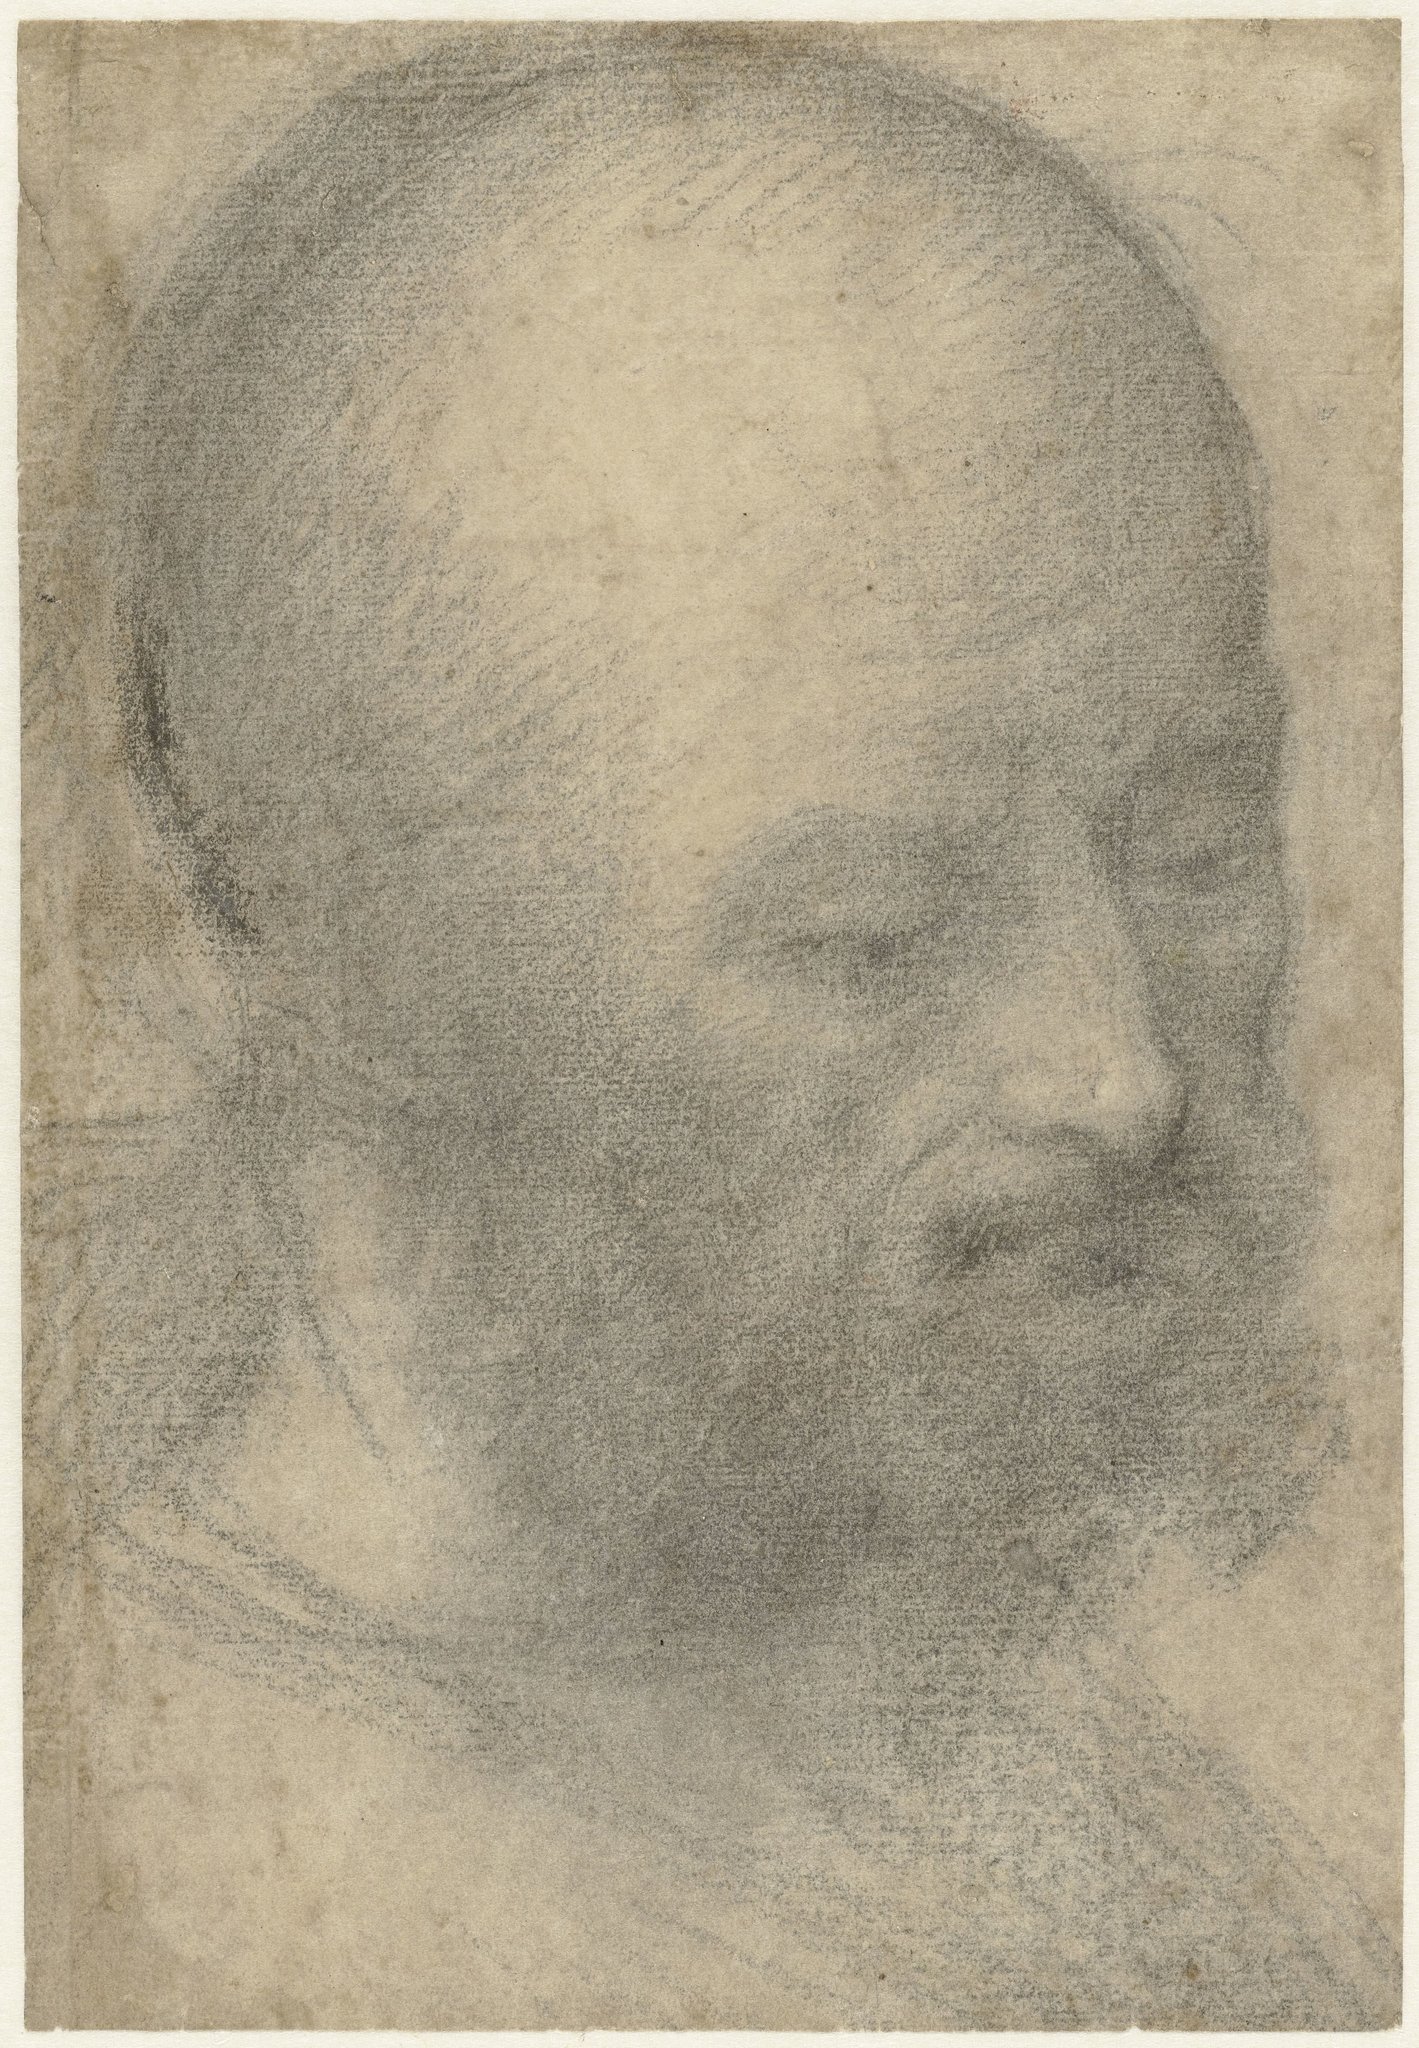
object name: drawing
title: Hoofd van een oude man met baard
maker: lorenzo costa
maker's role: painter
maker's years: 1460-1535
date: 1500-1506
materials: chalk, paper